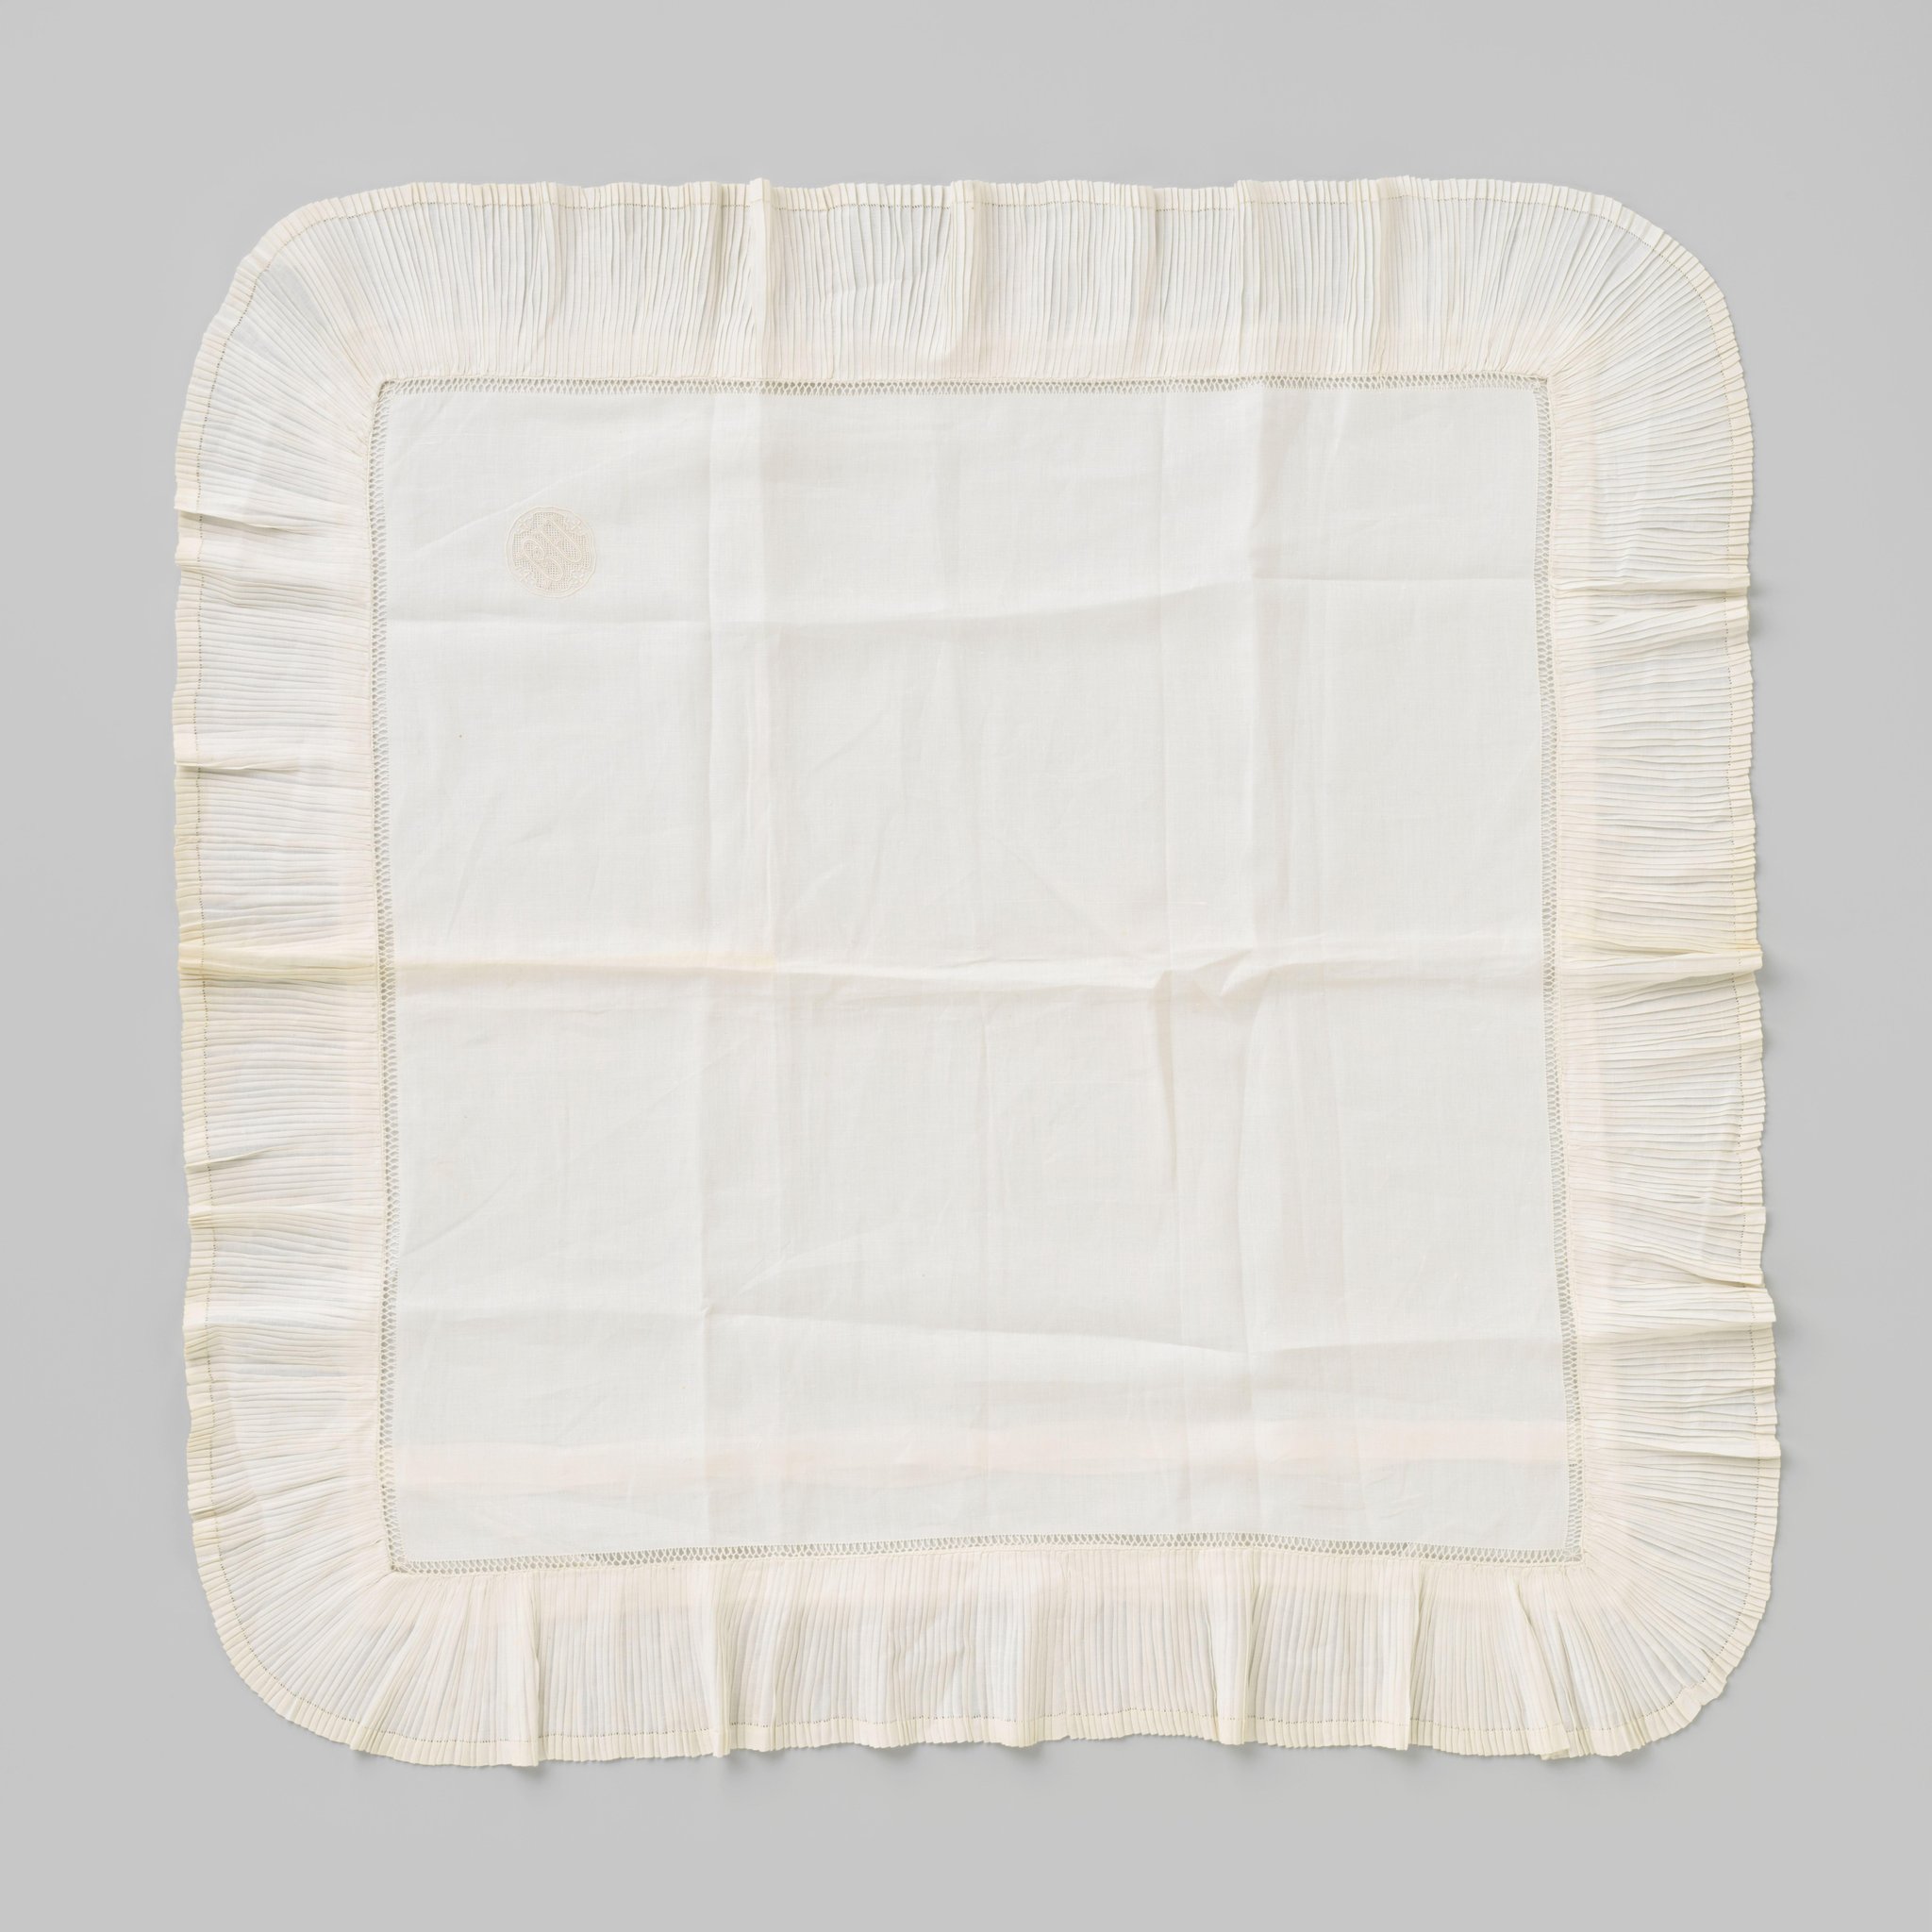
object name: pillowcase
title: Kussensloop van linnen met aangezette geplooide strook en de initialen BU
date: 1935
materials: linen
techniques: embroidered, weave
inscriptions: initials: ‘BU’, laundry mark: ‘4587 Plissé // Recommandé’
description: Kussensloop van linnen in platbinding, met een aangezette geplooide strook. De bovenzijde is versierd een inzet met de initialen BU (Brusse-Urtebise). De kussensloop heeft een wasmerk.